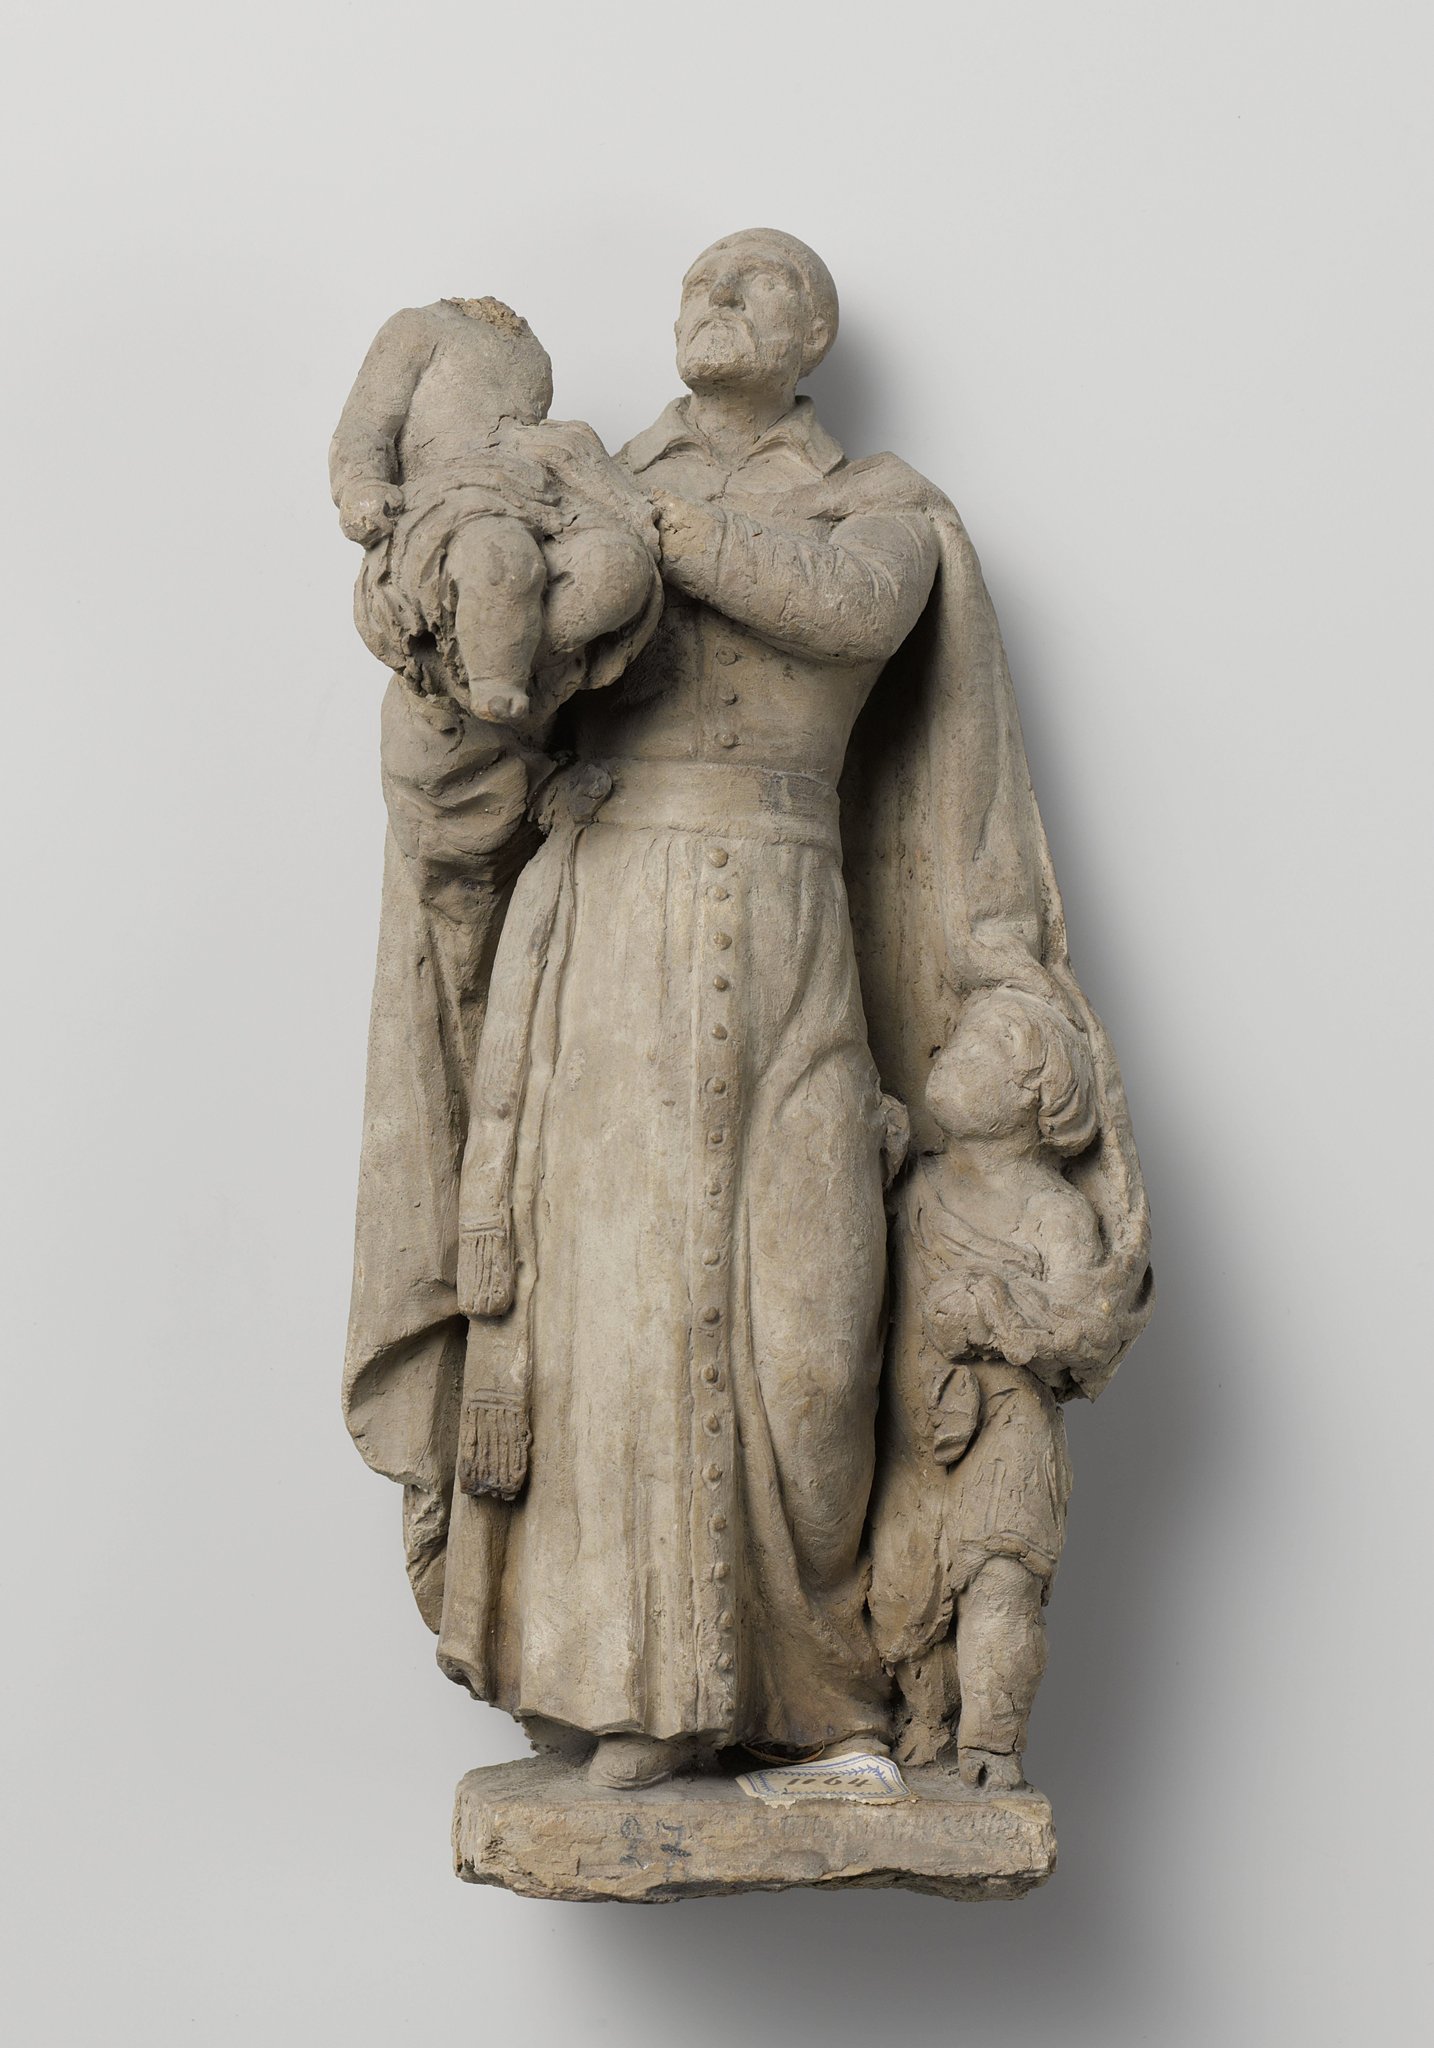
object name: sculpture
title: St. Vincentius van Paolo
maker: eugène lacomblé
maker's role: draughtsman, painter, sculptor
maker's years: 1828-1905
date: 1800-1900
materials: clay